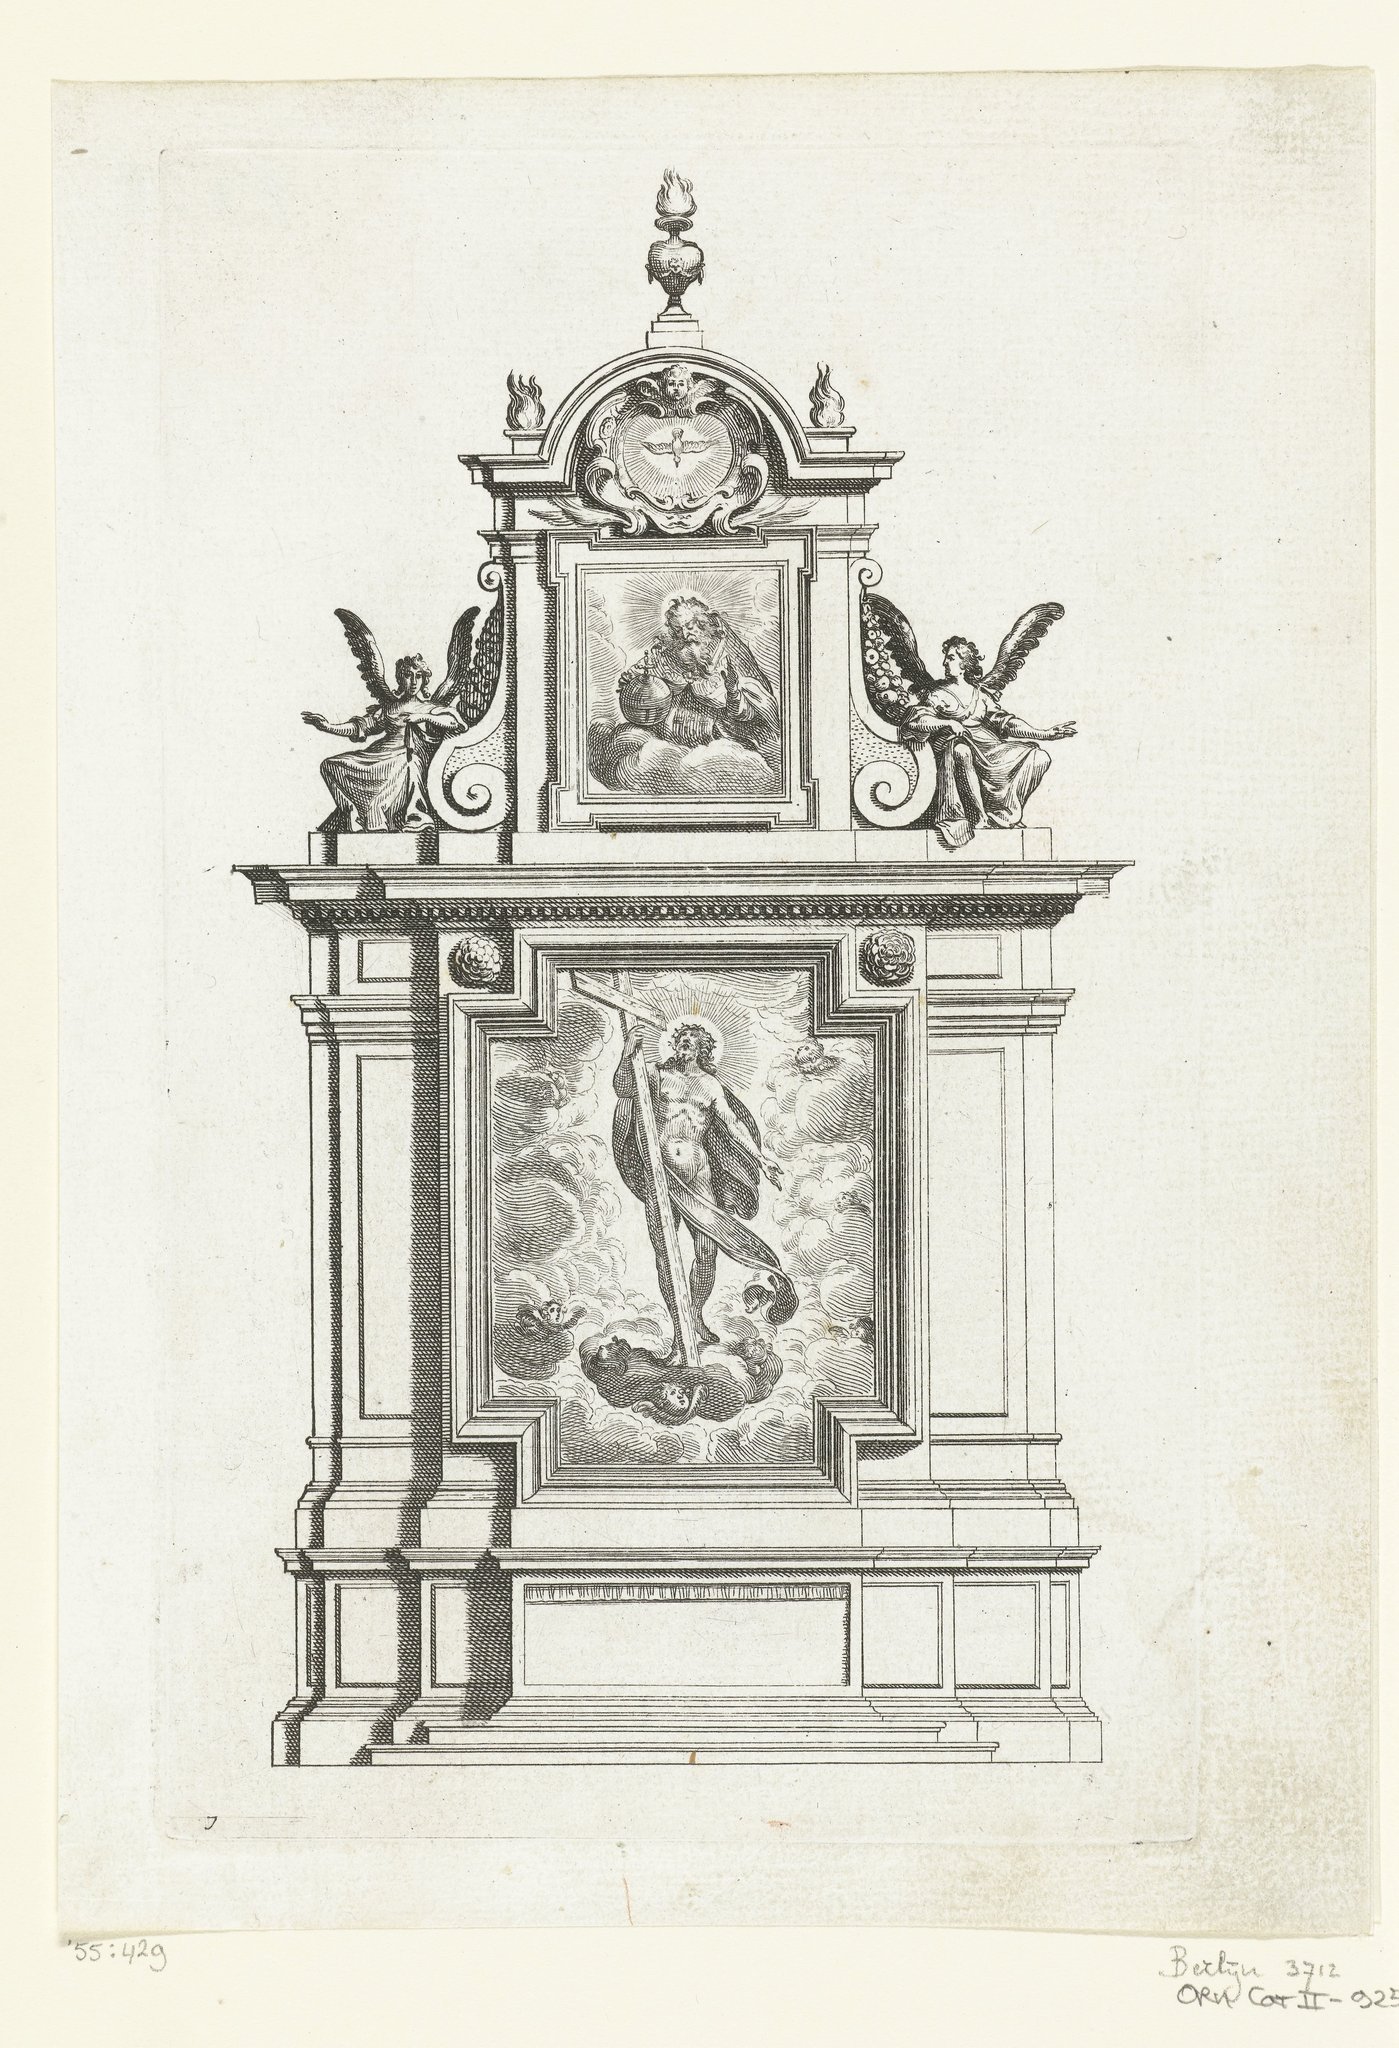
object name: ornament print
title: Livre d' Architecture et d' Autels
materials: paper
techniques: etching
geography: france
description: Christus houdt het kruis vast. Blad 7 uit tweede uitgave van serie. De nummering van de prenten komt slechts gedeeltelijk overeen met die van de eerste editie.